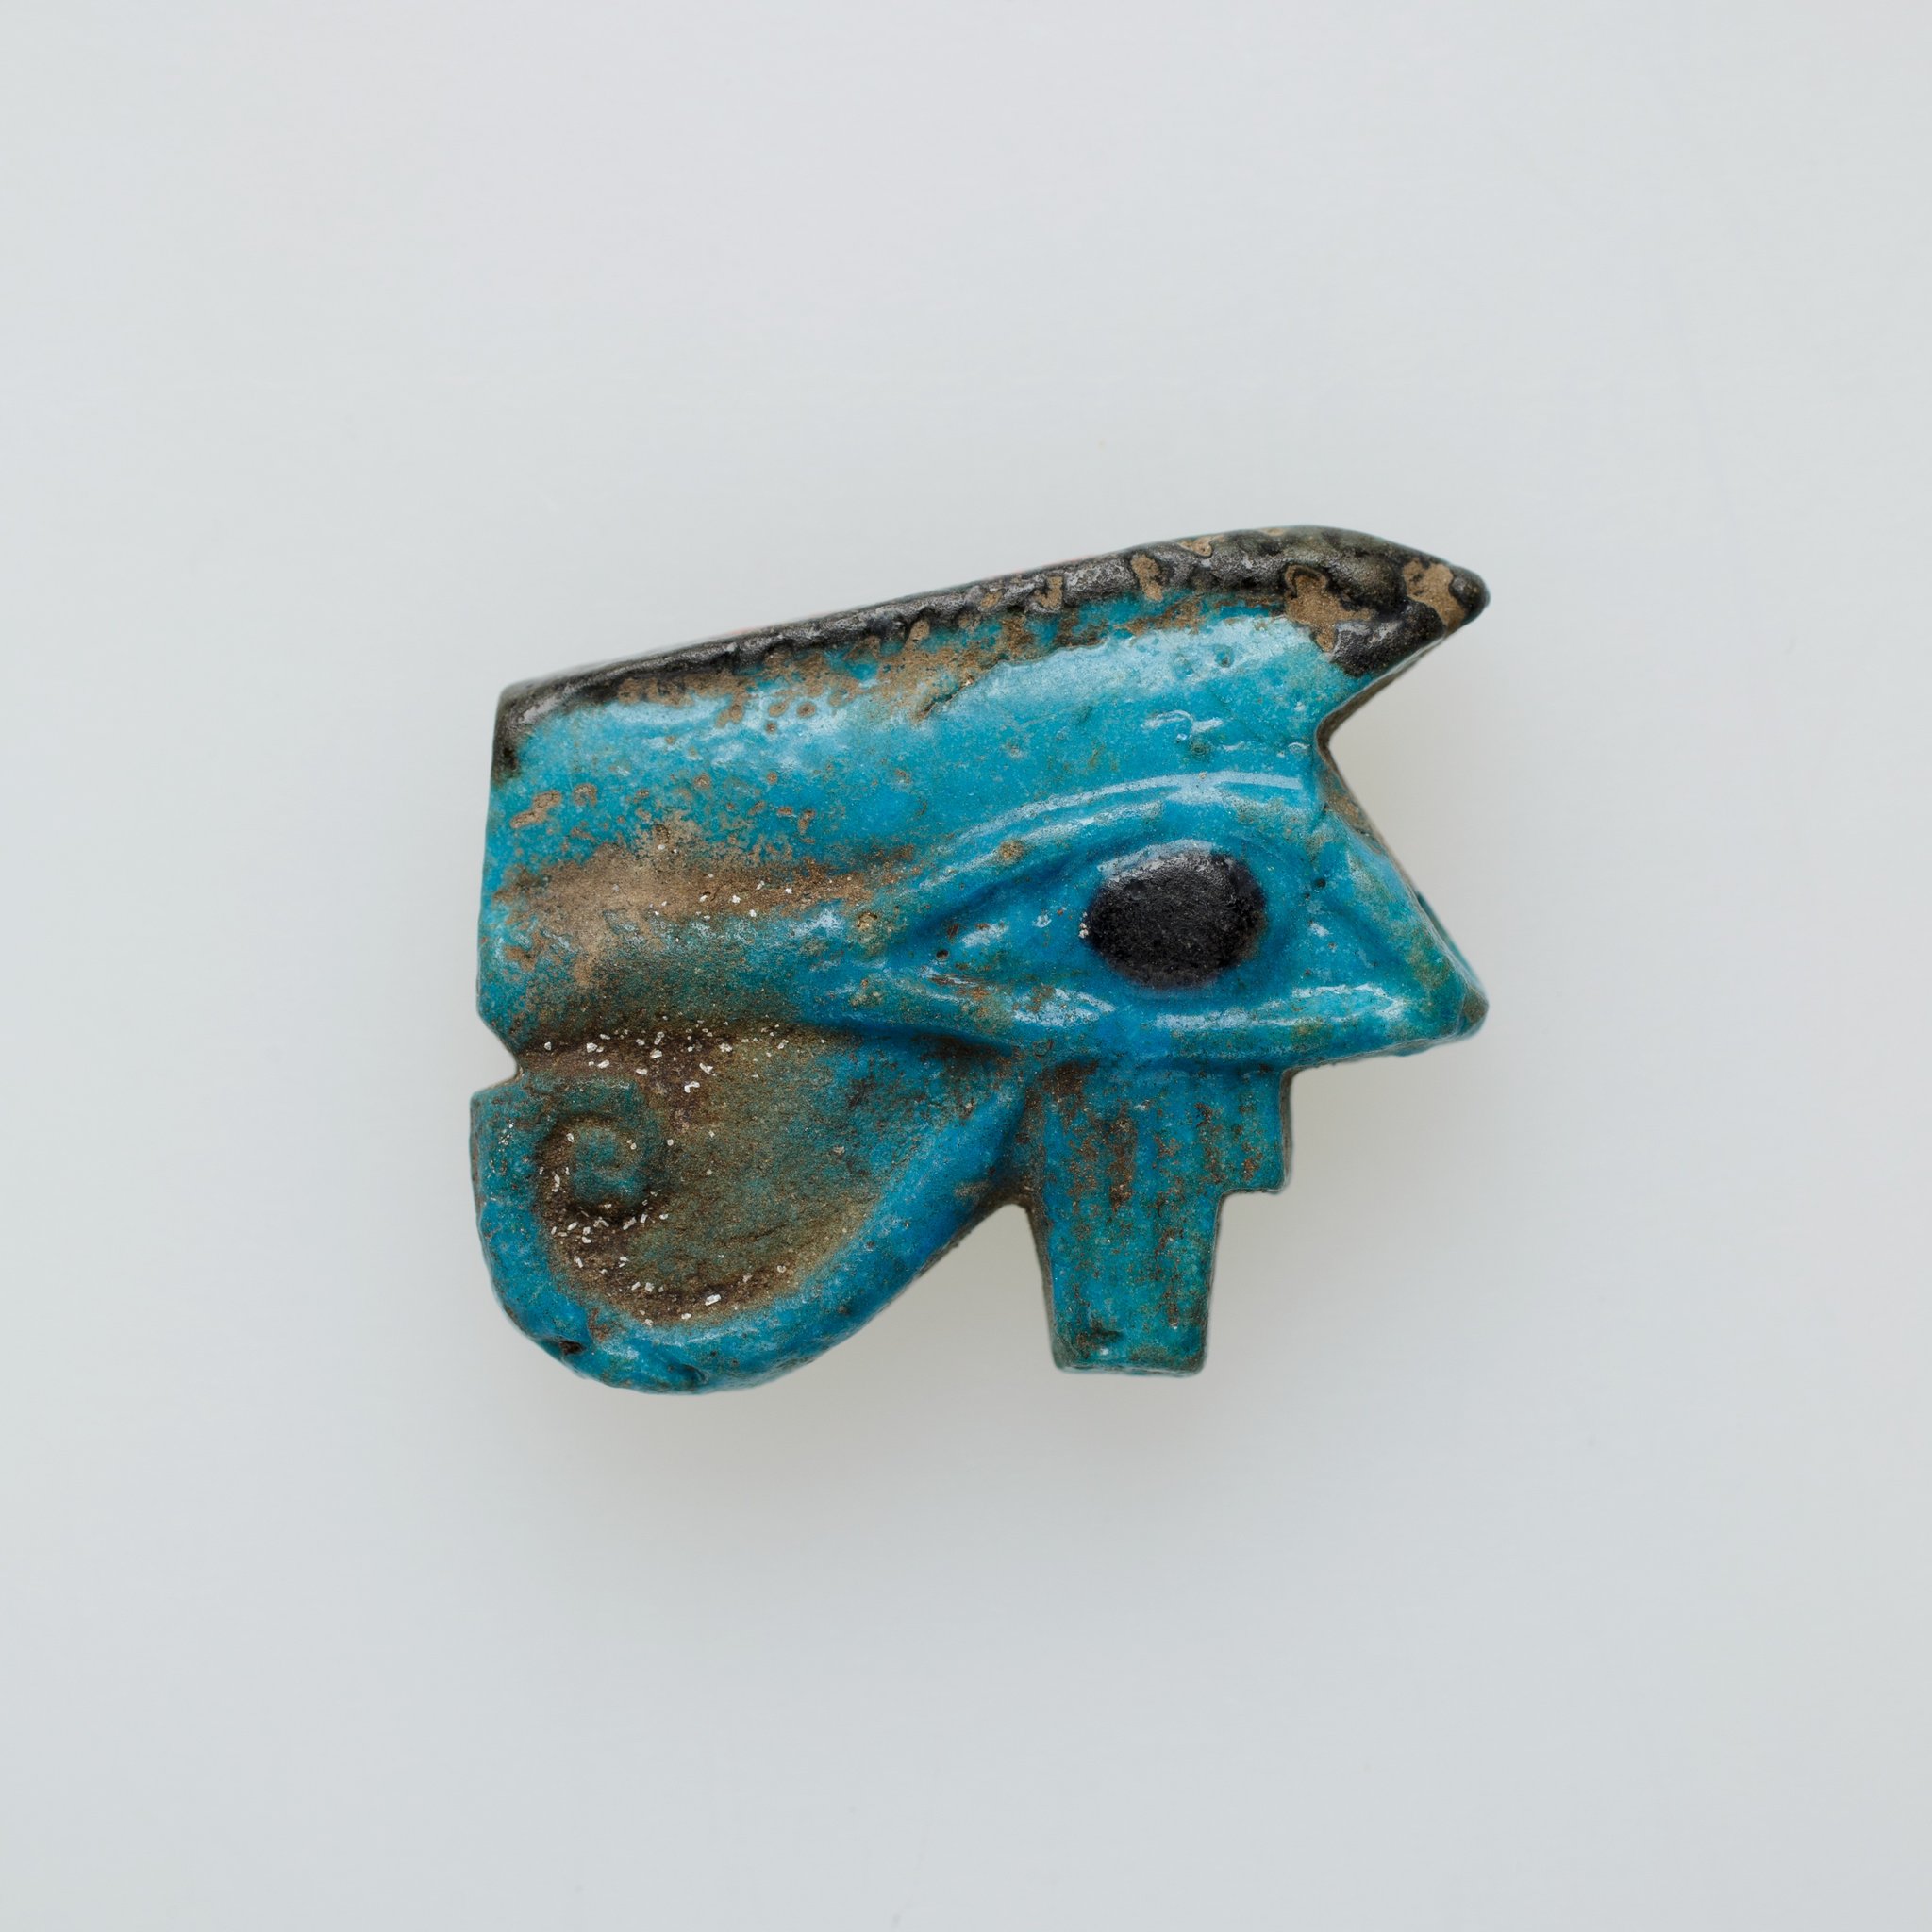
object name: amulet, wedjat eye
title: Wedjat eye amulet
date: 1070-664 BCE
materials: faience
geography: egypt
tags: eyes